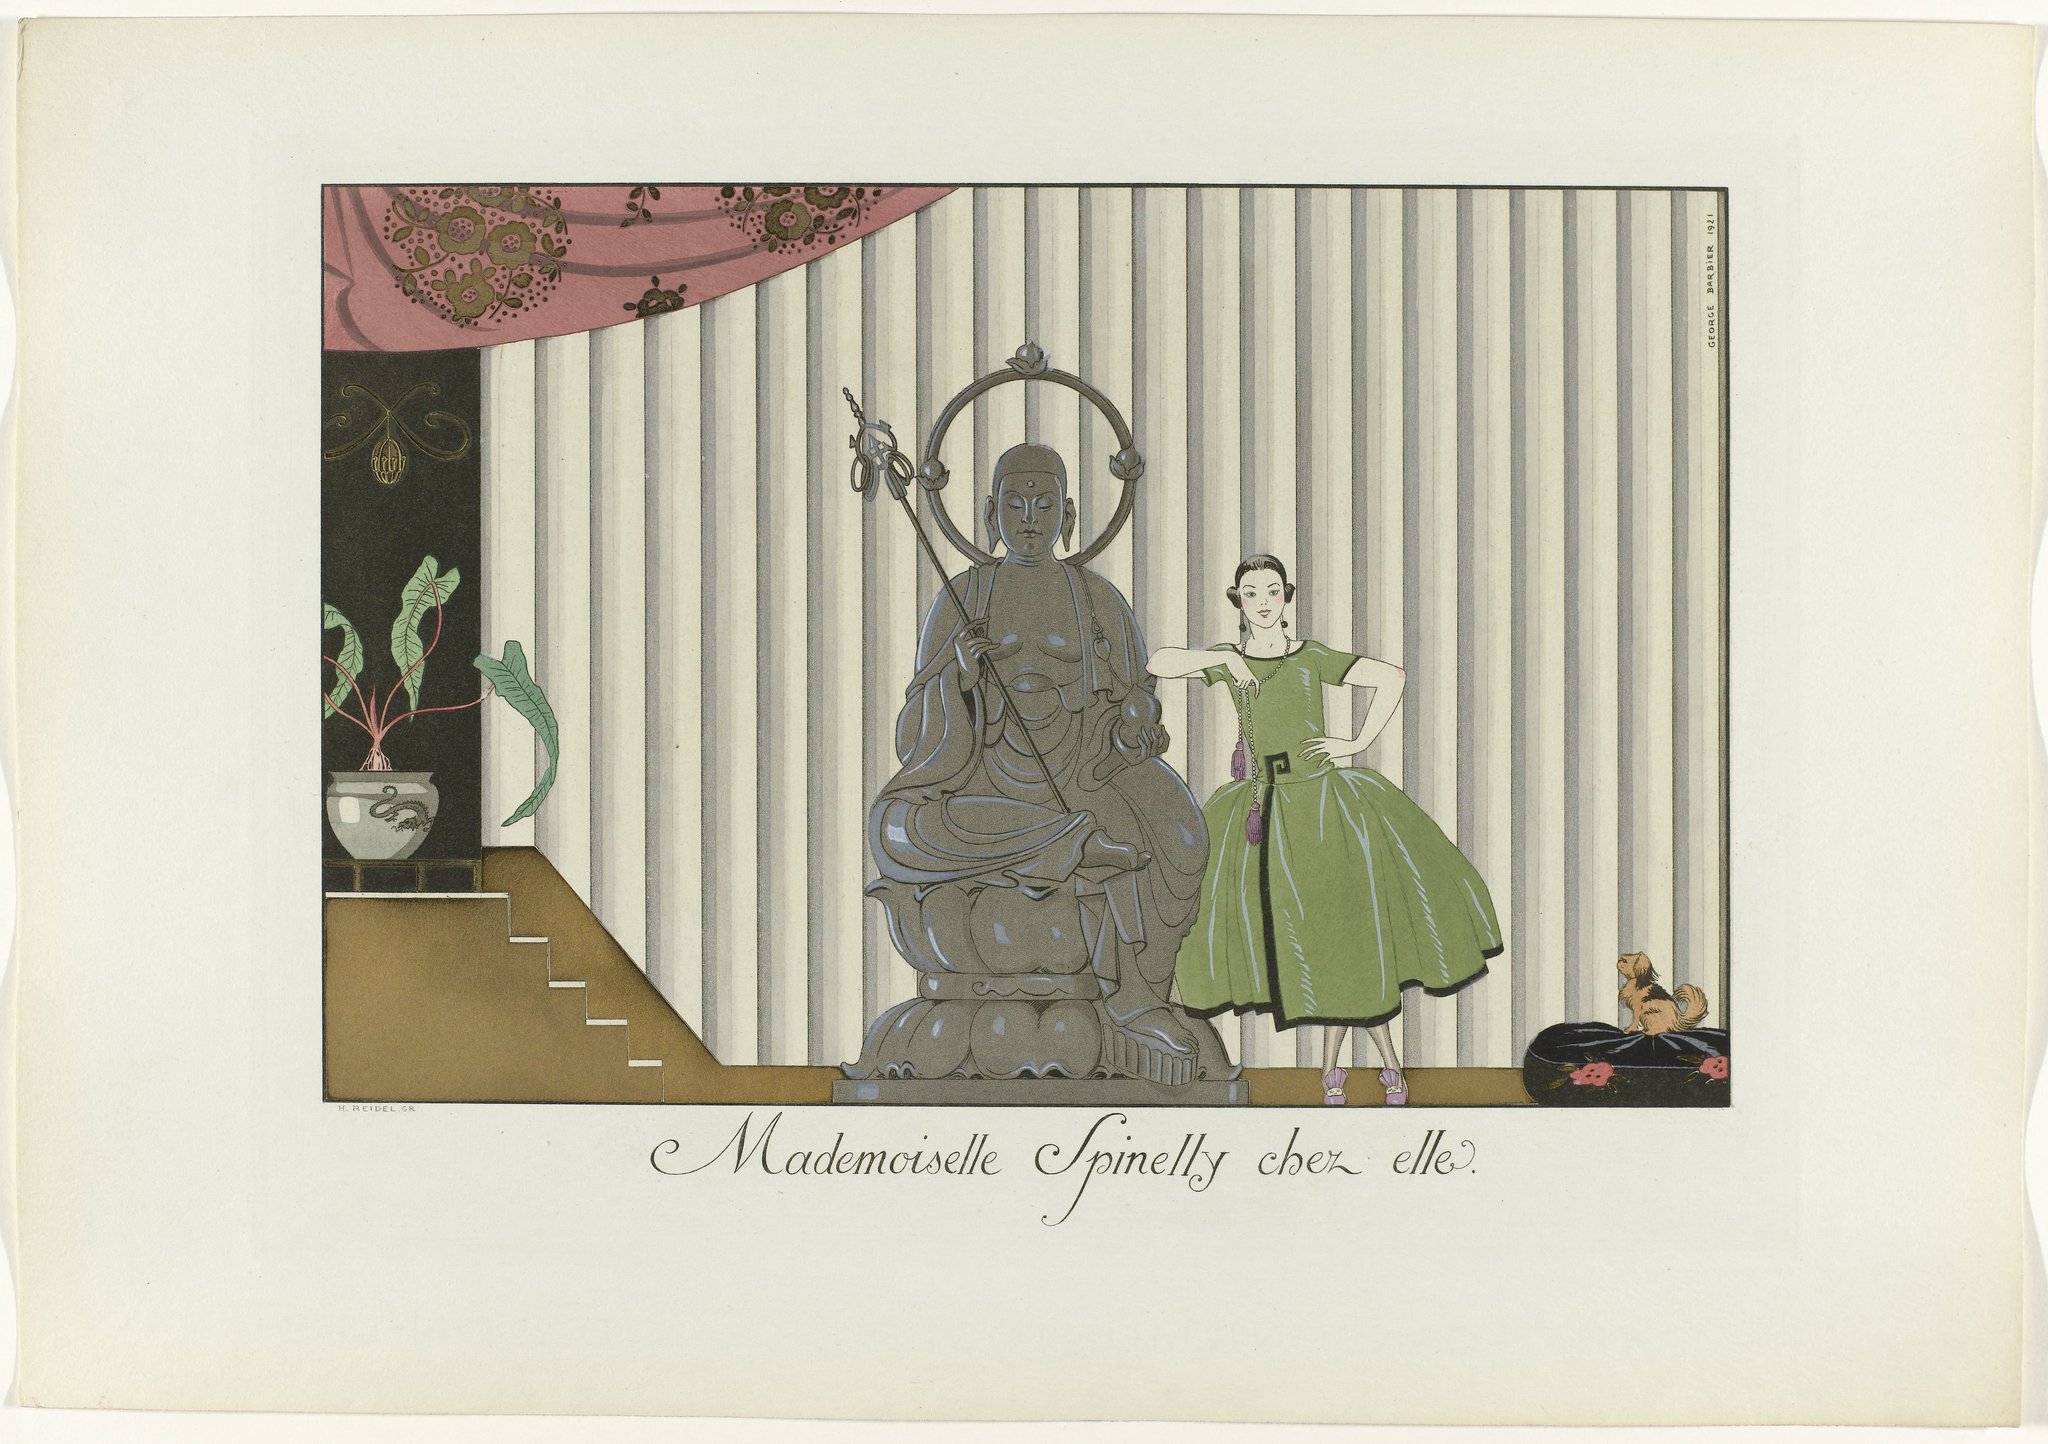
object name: fashion print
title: Mademoiselle Spinelly chez elle.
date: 1921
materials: paper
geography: paris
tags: fashion plates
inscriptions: date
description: Uit serie Le Bonheur du Jour ou Les Graces à la Mode.